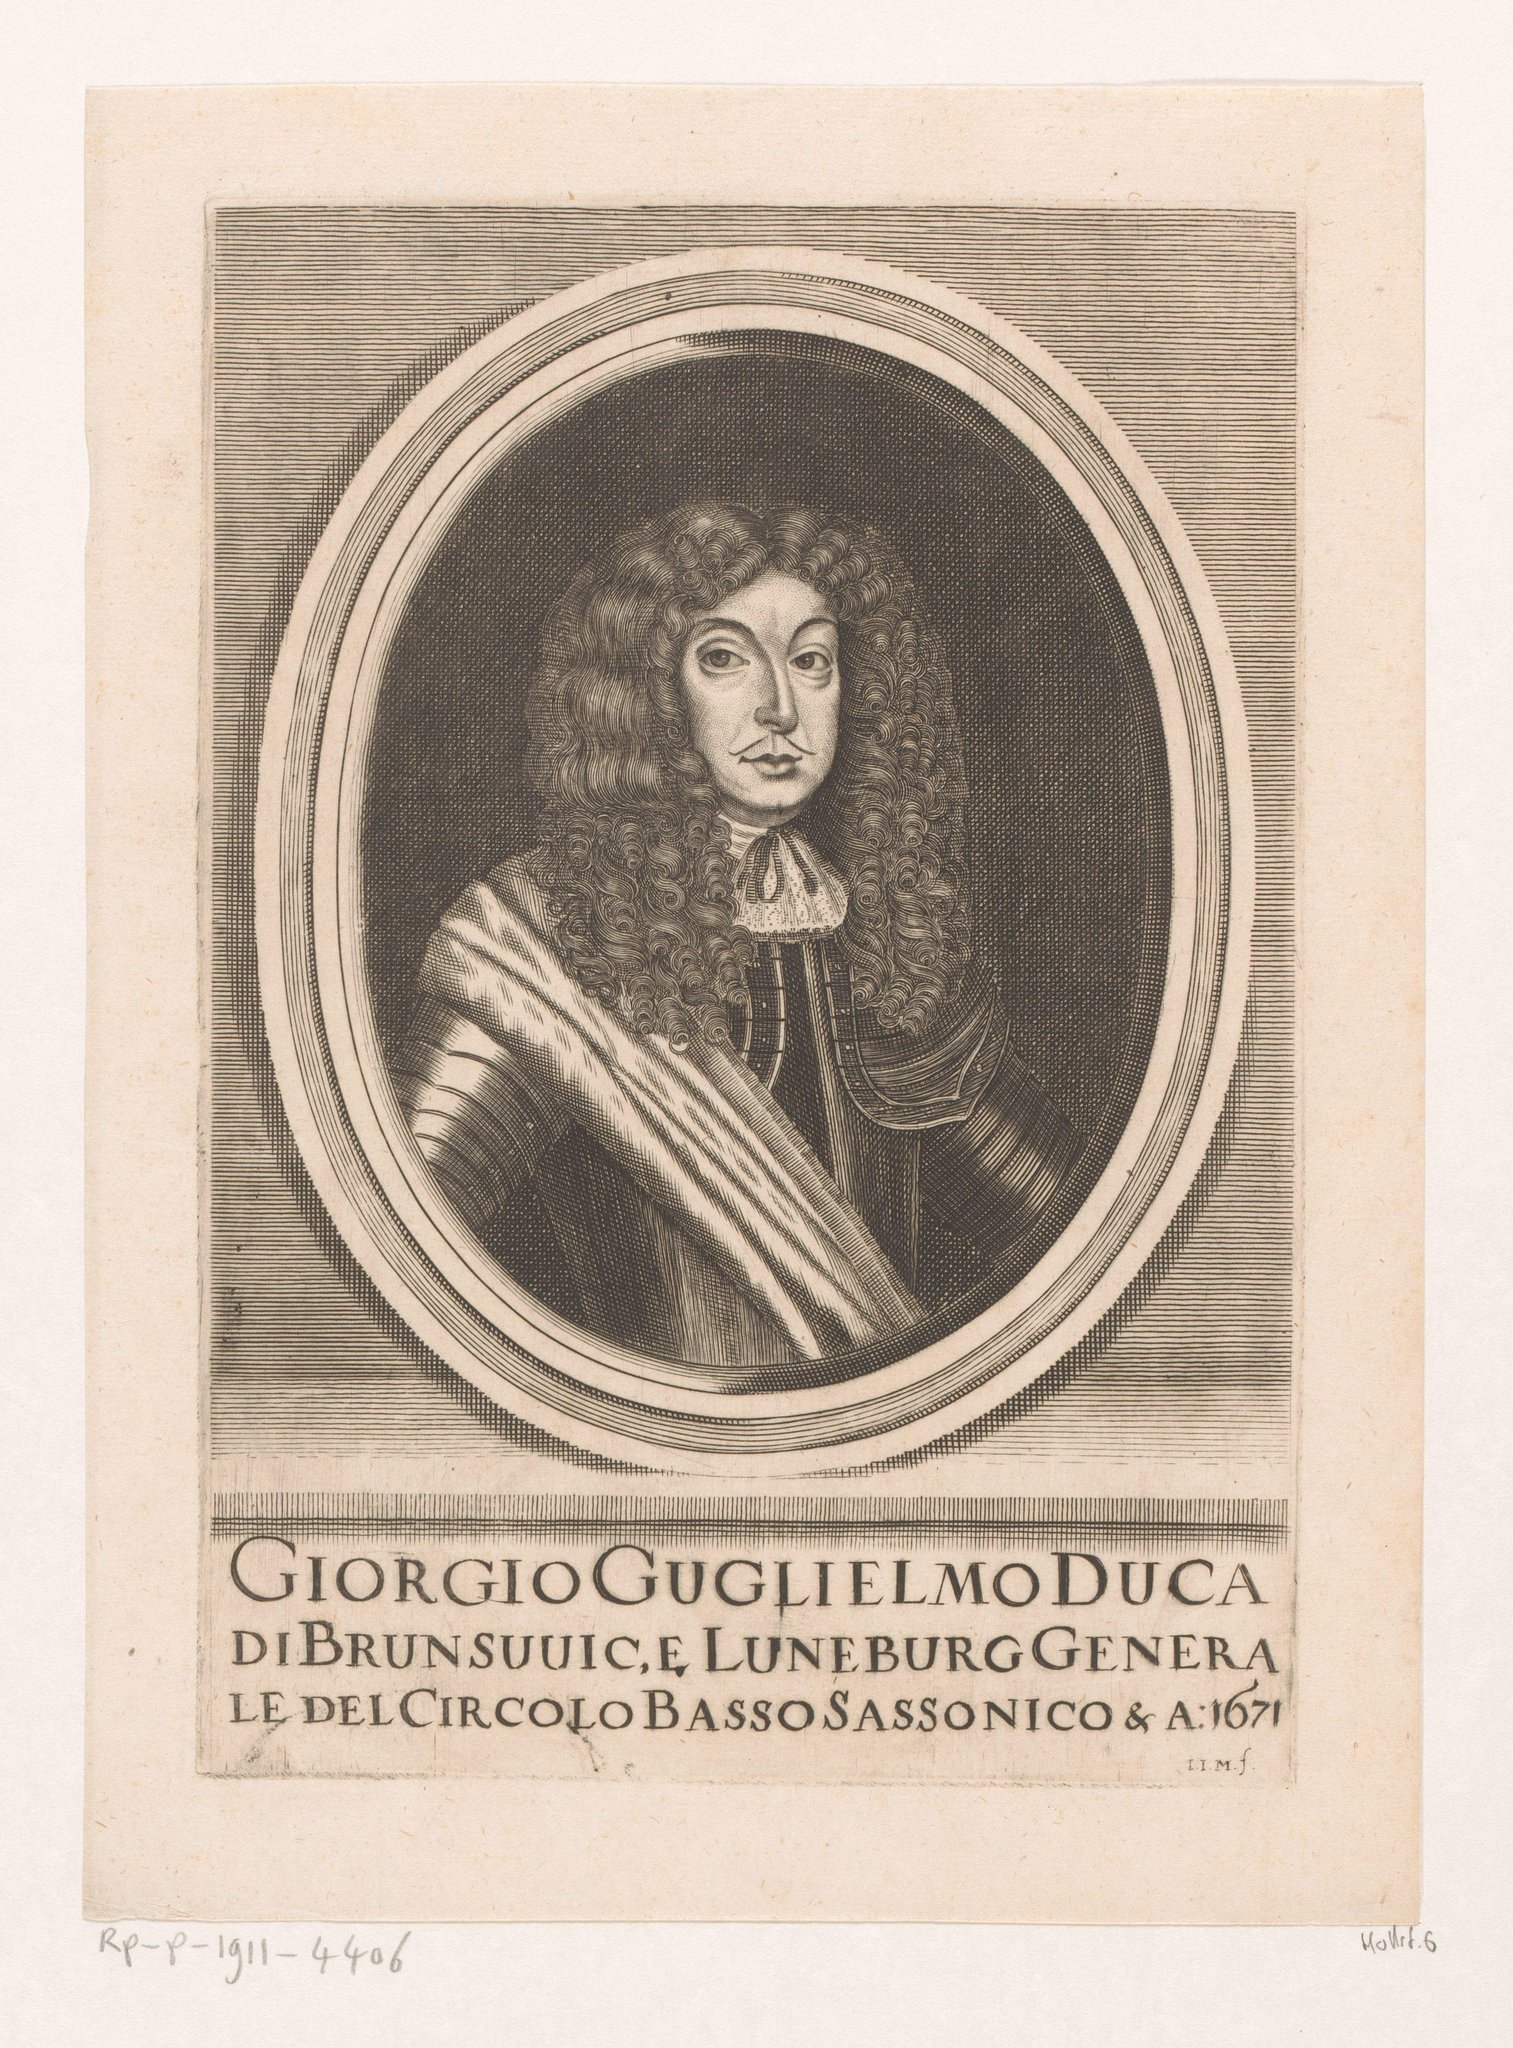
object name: print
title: Portret van Georg Willem hertog van Brunswijk-Lüneburg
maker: johann jakob metzger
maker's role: print maker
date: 1673-1675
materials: paper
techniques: engraving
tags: armour, historical persons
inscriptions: collector's mark: Lugt 2228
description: Prent ook gebruikt in: Galeazzo, Gualdo Priorato. Historia di Leopoldo Cesare, continente le cose piu memorabili successe in Europa, dal 1656 fino al 1670. Wenen: Battista Hacque, 1674.